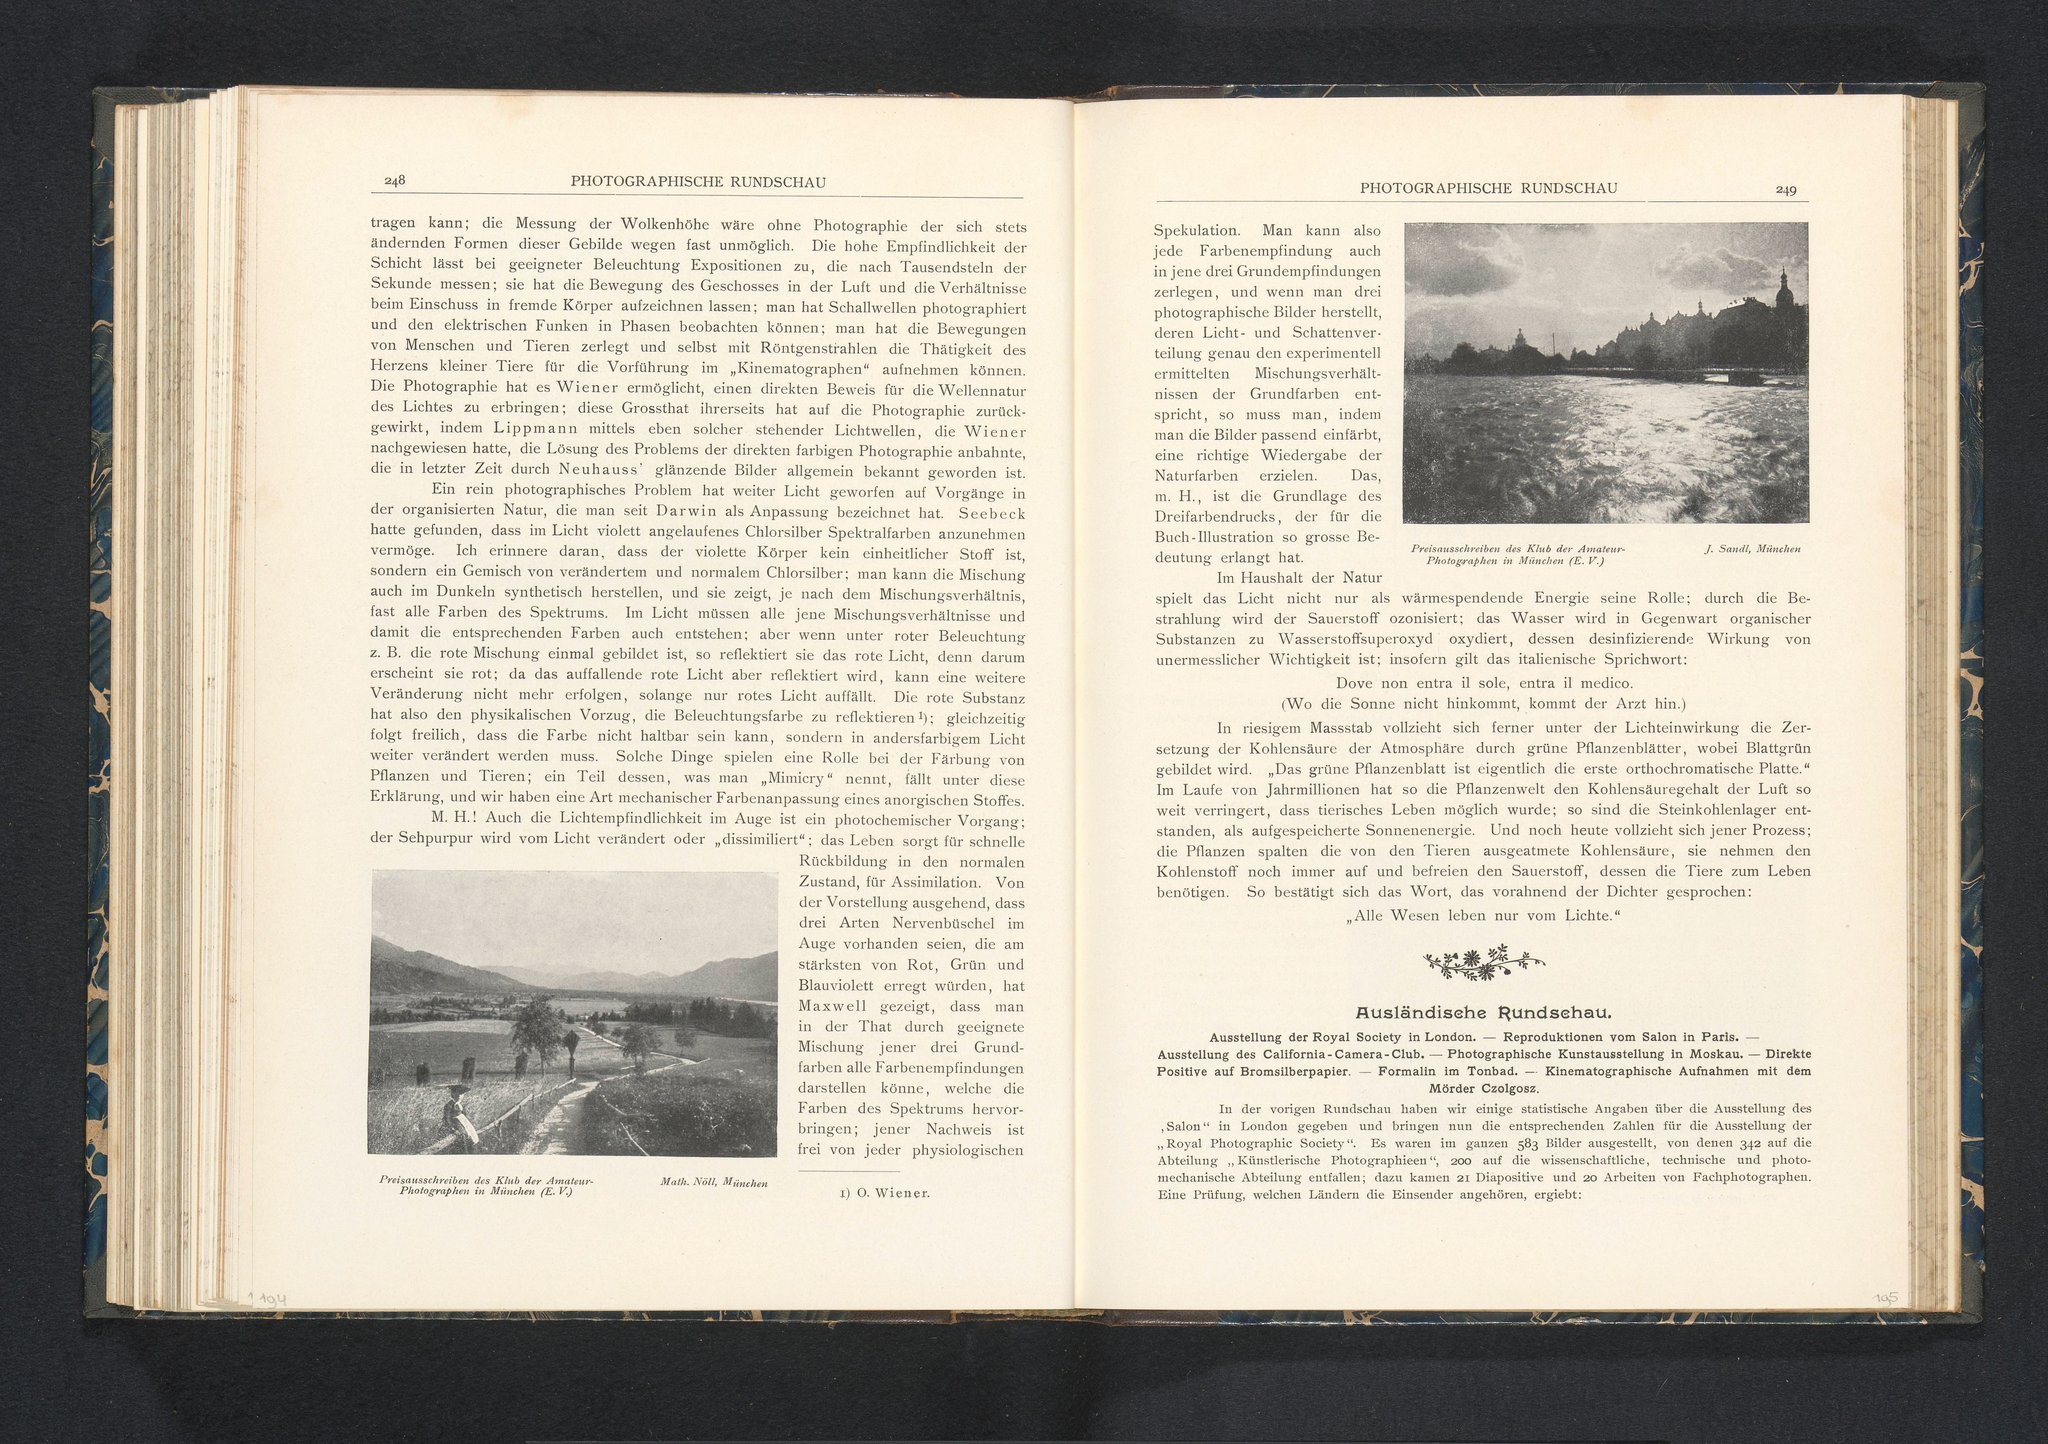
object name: photomechanical print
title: Gezicht op een stad aan het water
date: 1896-1901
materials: paper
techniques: autotype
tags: city-view, and landscape with man-made constructions, river